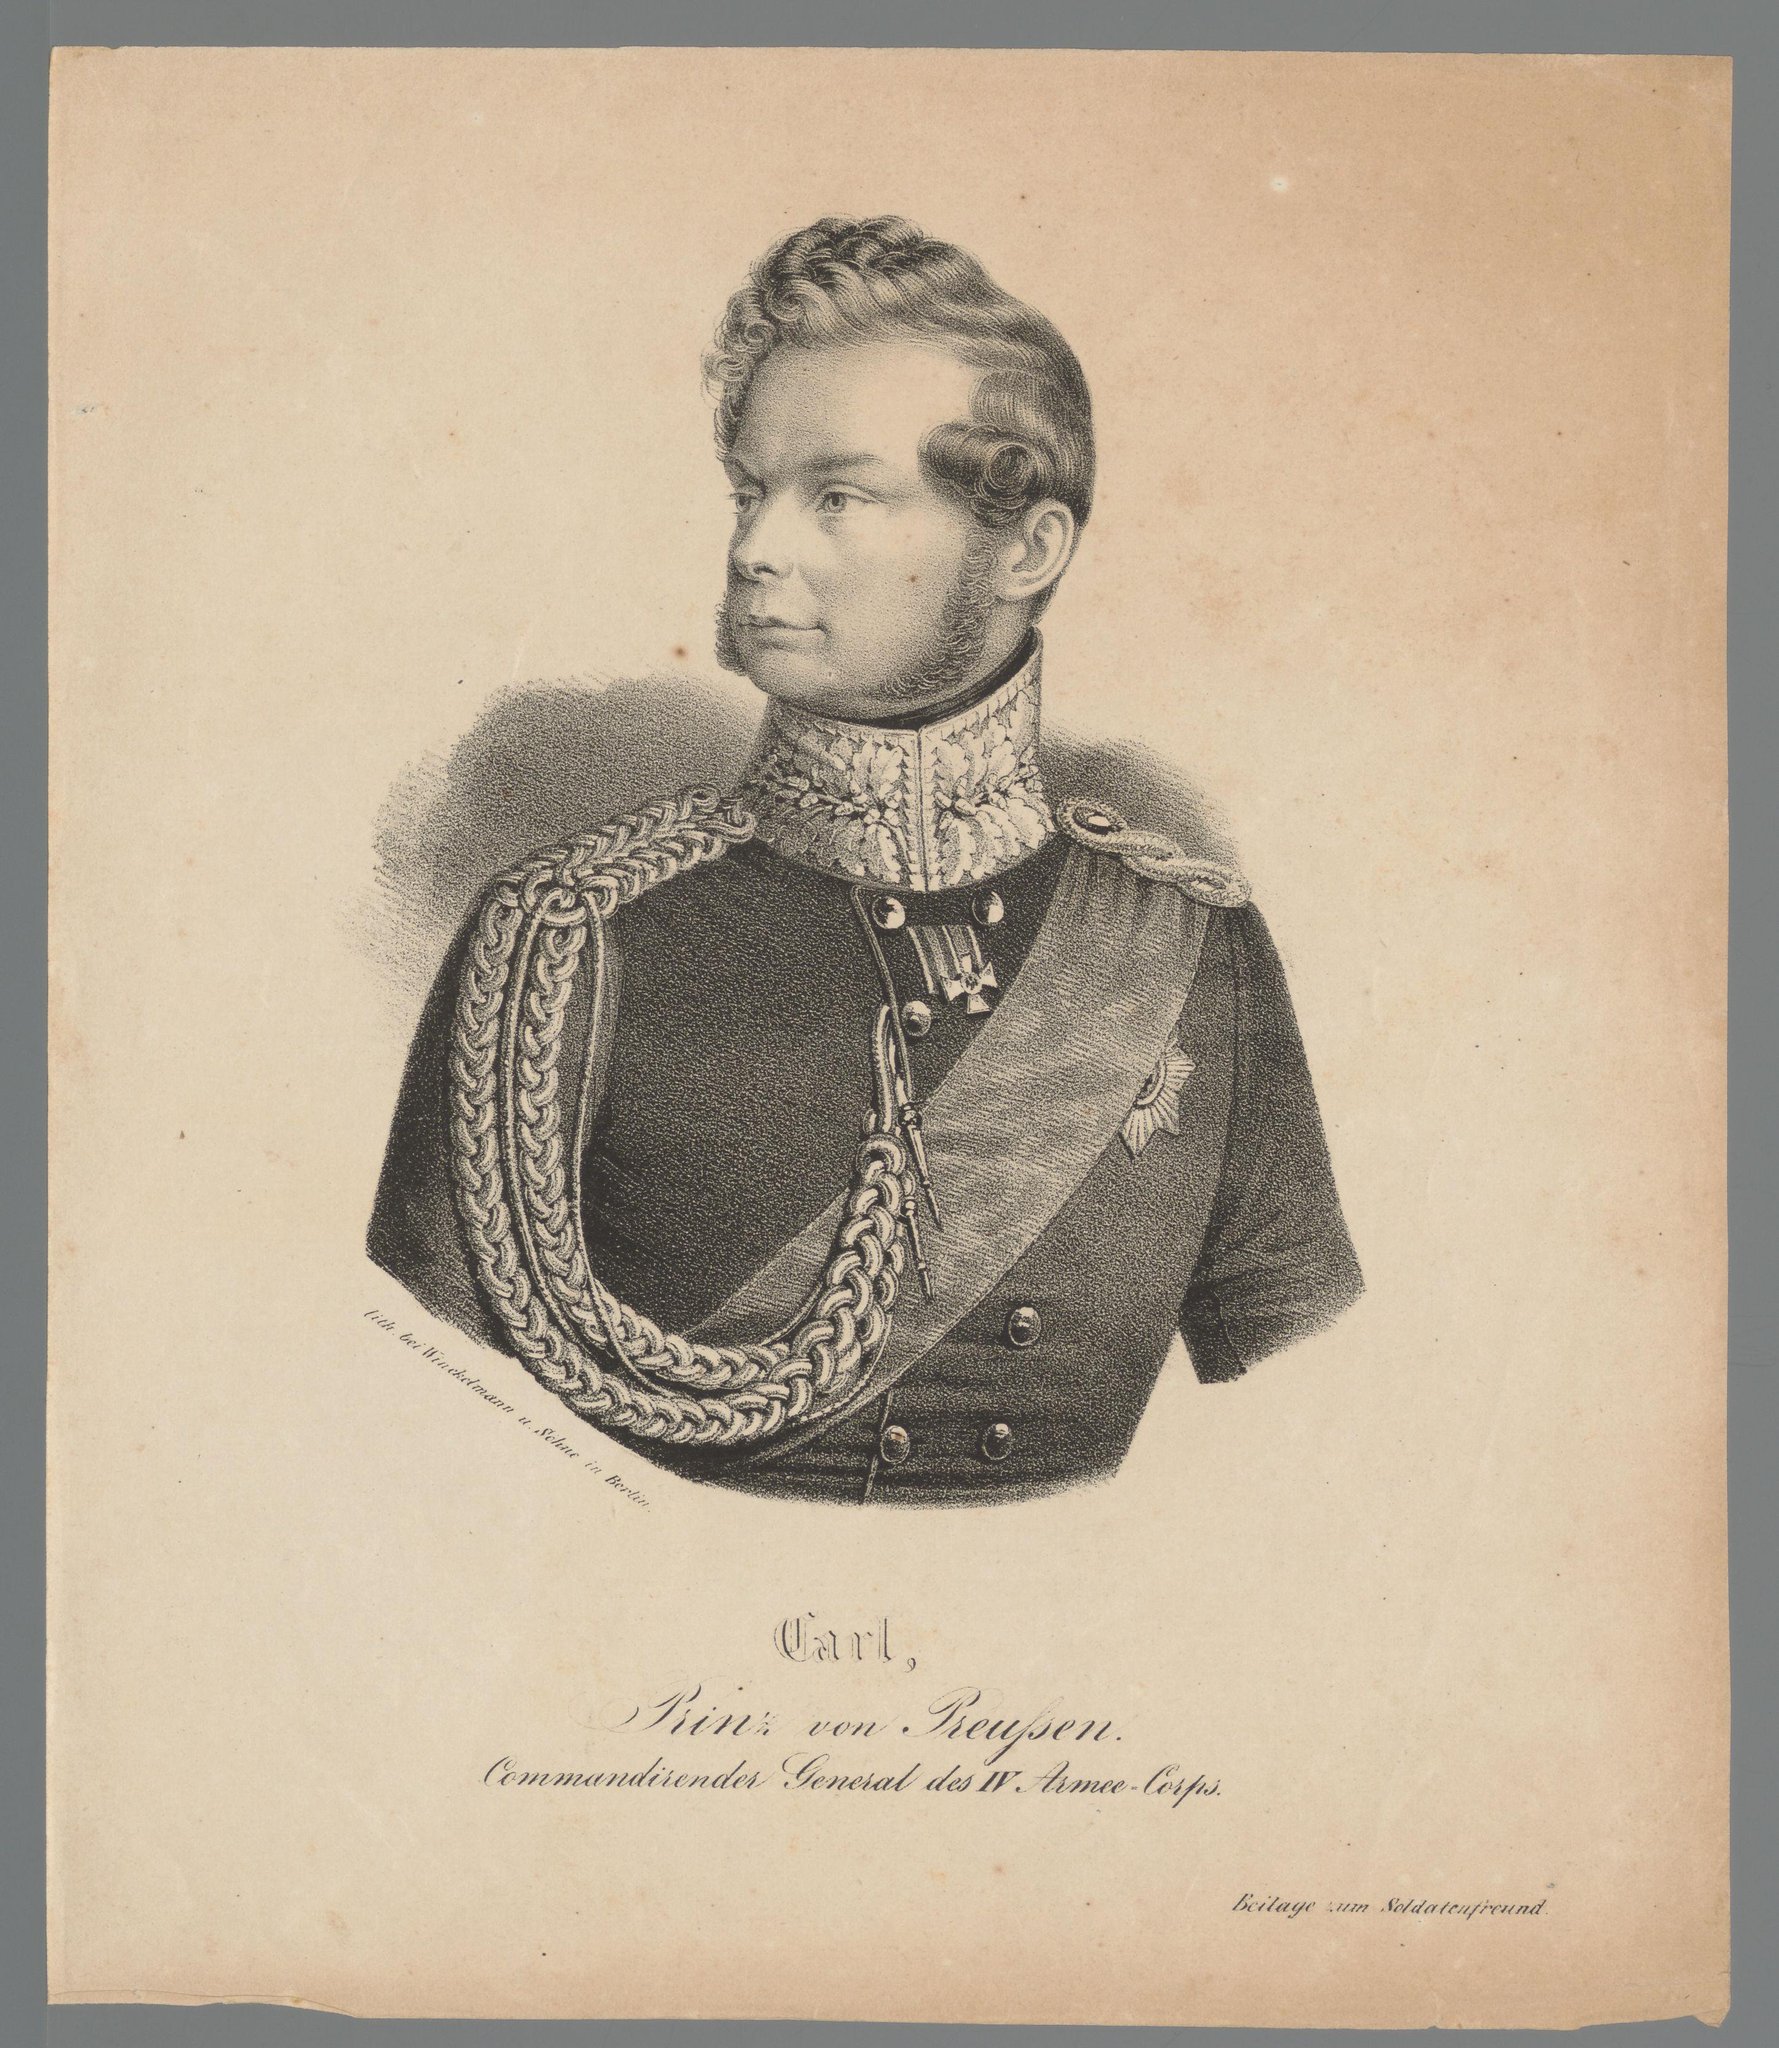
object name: print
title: Portret van Karel, prins van Pruisen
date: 1830-1860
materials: paper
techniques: lithograph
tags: adult man, historical persons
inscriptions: collector's mark: Lugt 2228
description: De prent is een bijlage bij een uitgave van 'Soldatenfreund'.